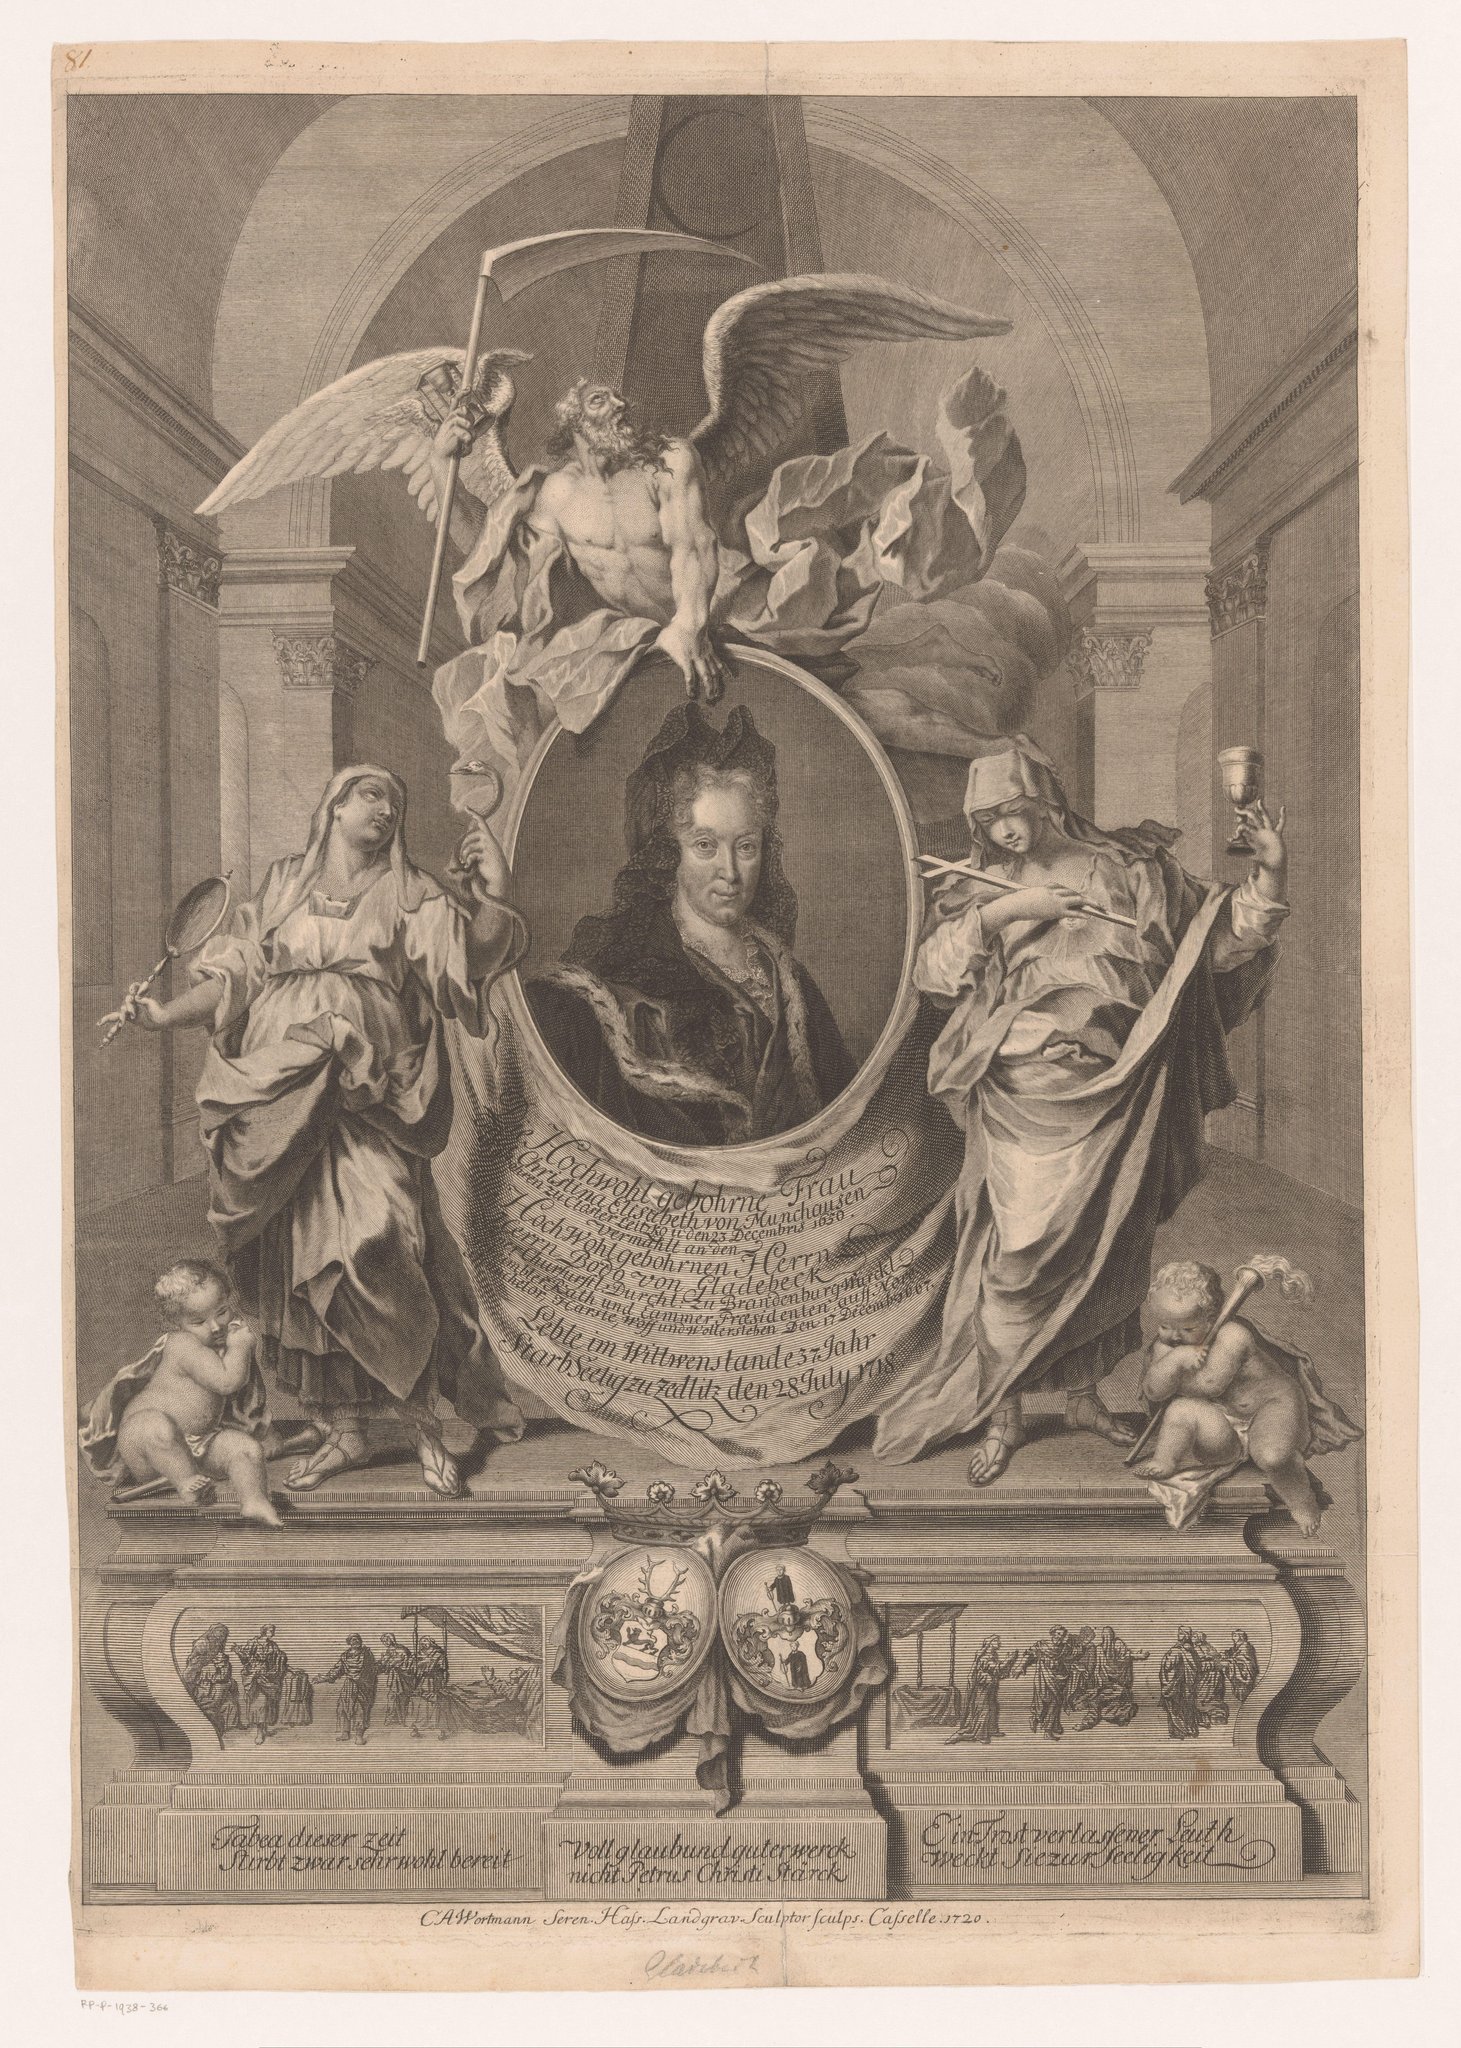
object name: print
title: Portret van Christine Elisabeth van Münchhausen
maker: christian albrecht wortmann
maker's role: print maker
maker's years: 1680-1760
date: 1720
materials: paper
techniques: engraving, etching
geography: kassel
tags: historical persons, father time, man with wings and scythe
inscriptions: collector's mark: Lugt 2228